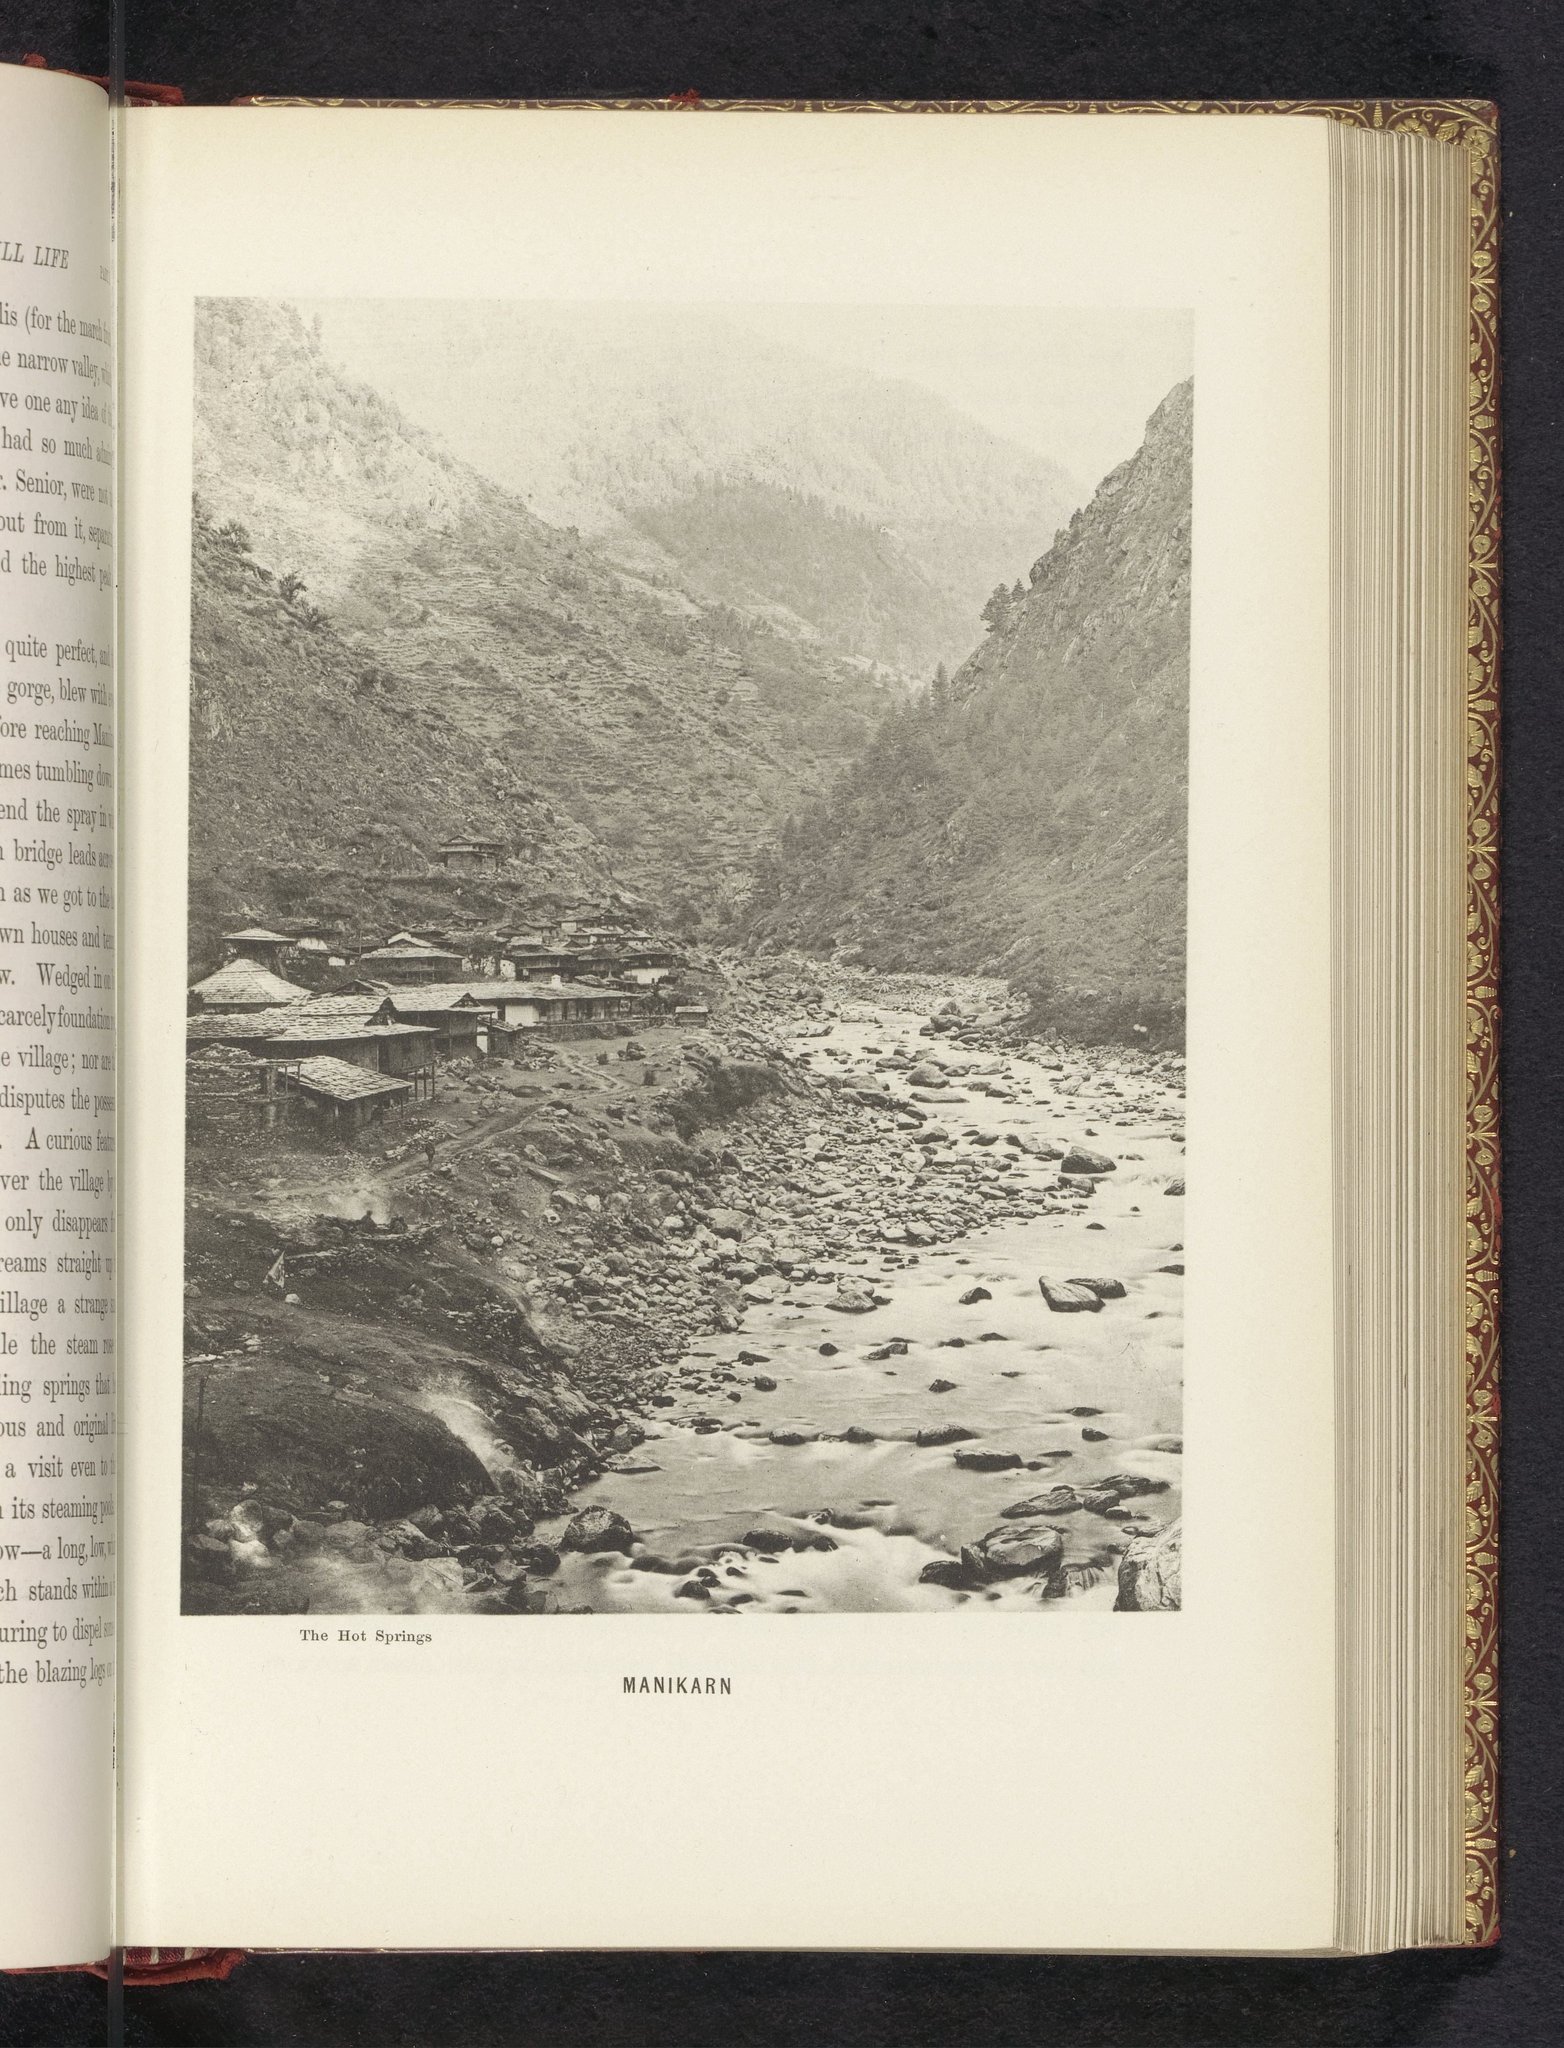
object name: photomechanical print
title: View of Manikaran, Himachal Pradesh, India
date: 1890-1895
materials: paper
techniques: photograph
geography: manikaran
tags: city-view in general; 'veduta', river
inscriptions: caption: ‘The Hot Springs/ MANIKARN’